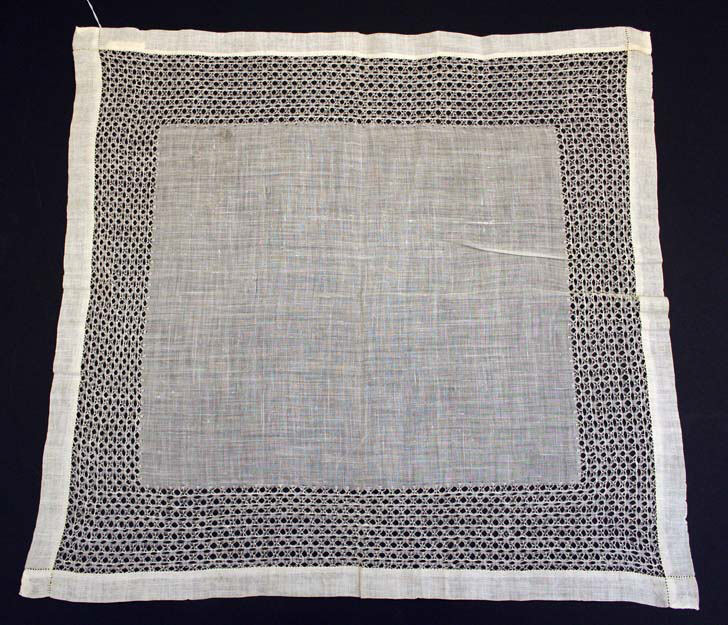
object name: handkerchief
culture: french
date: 1880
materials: linen